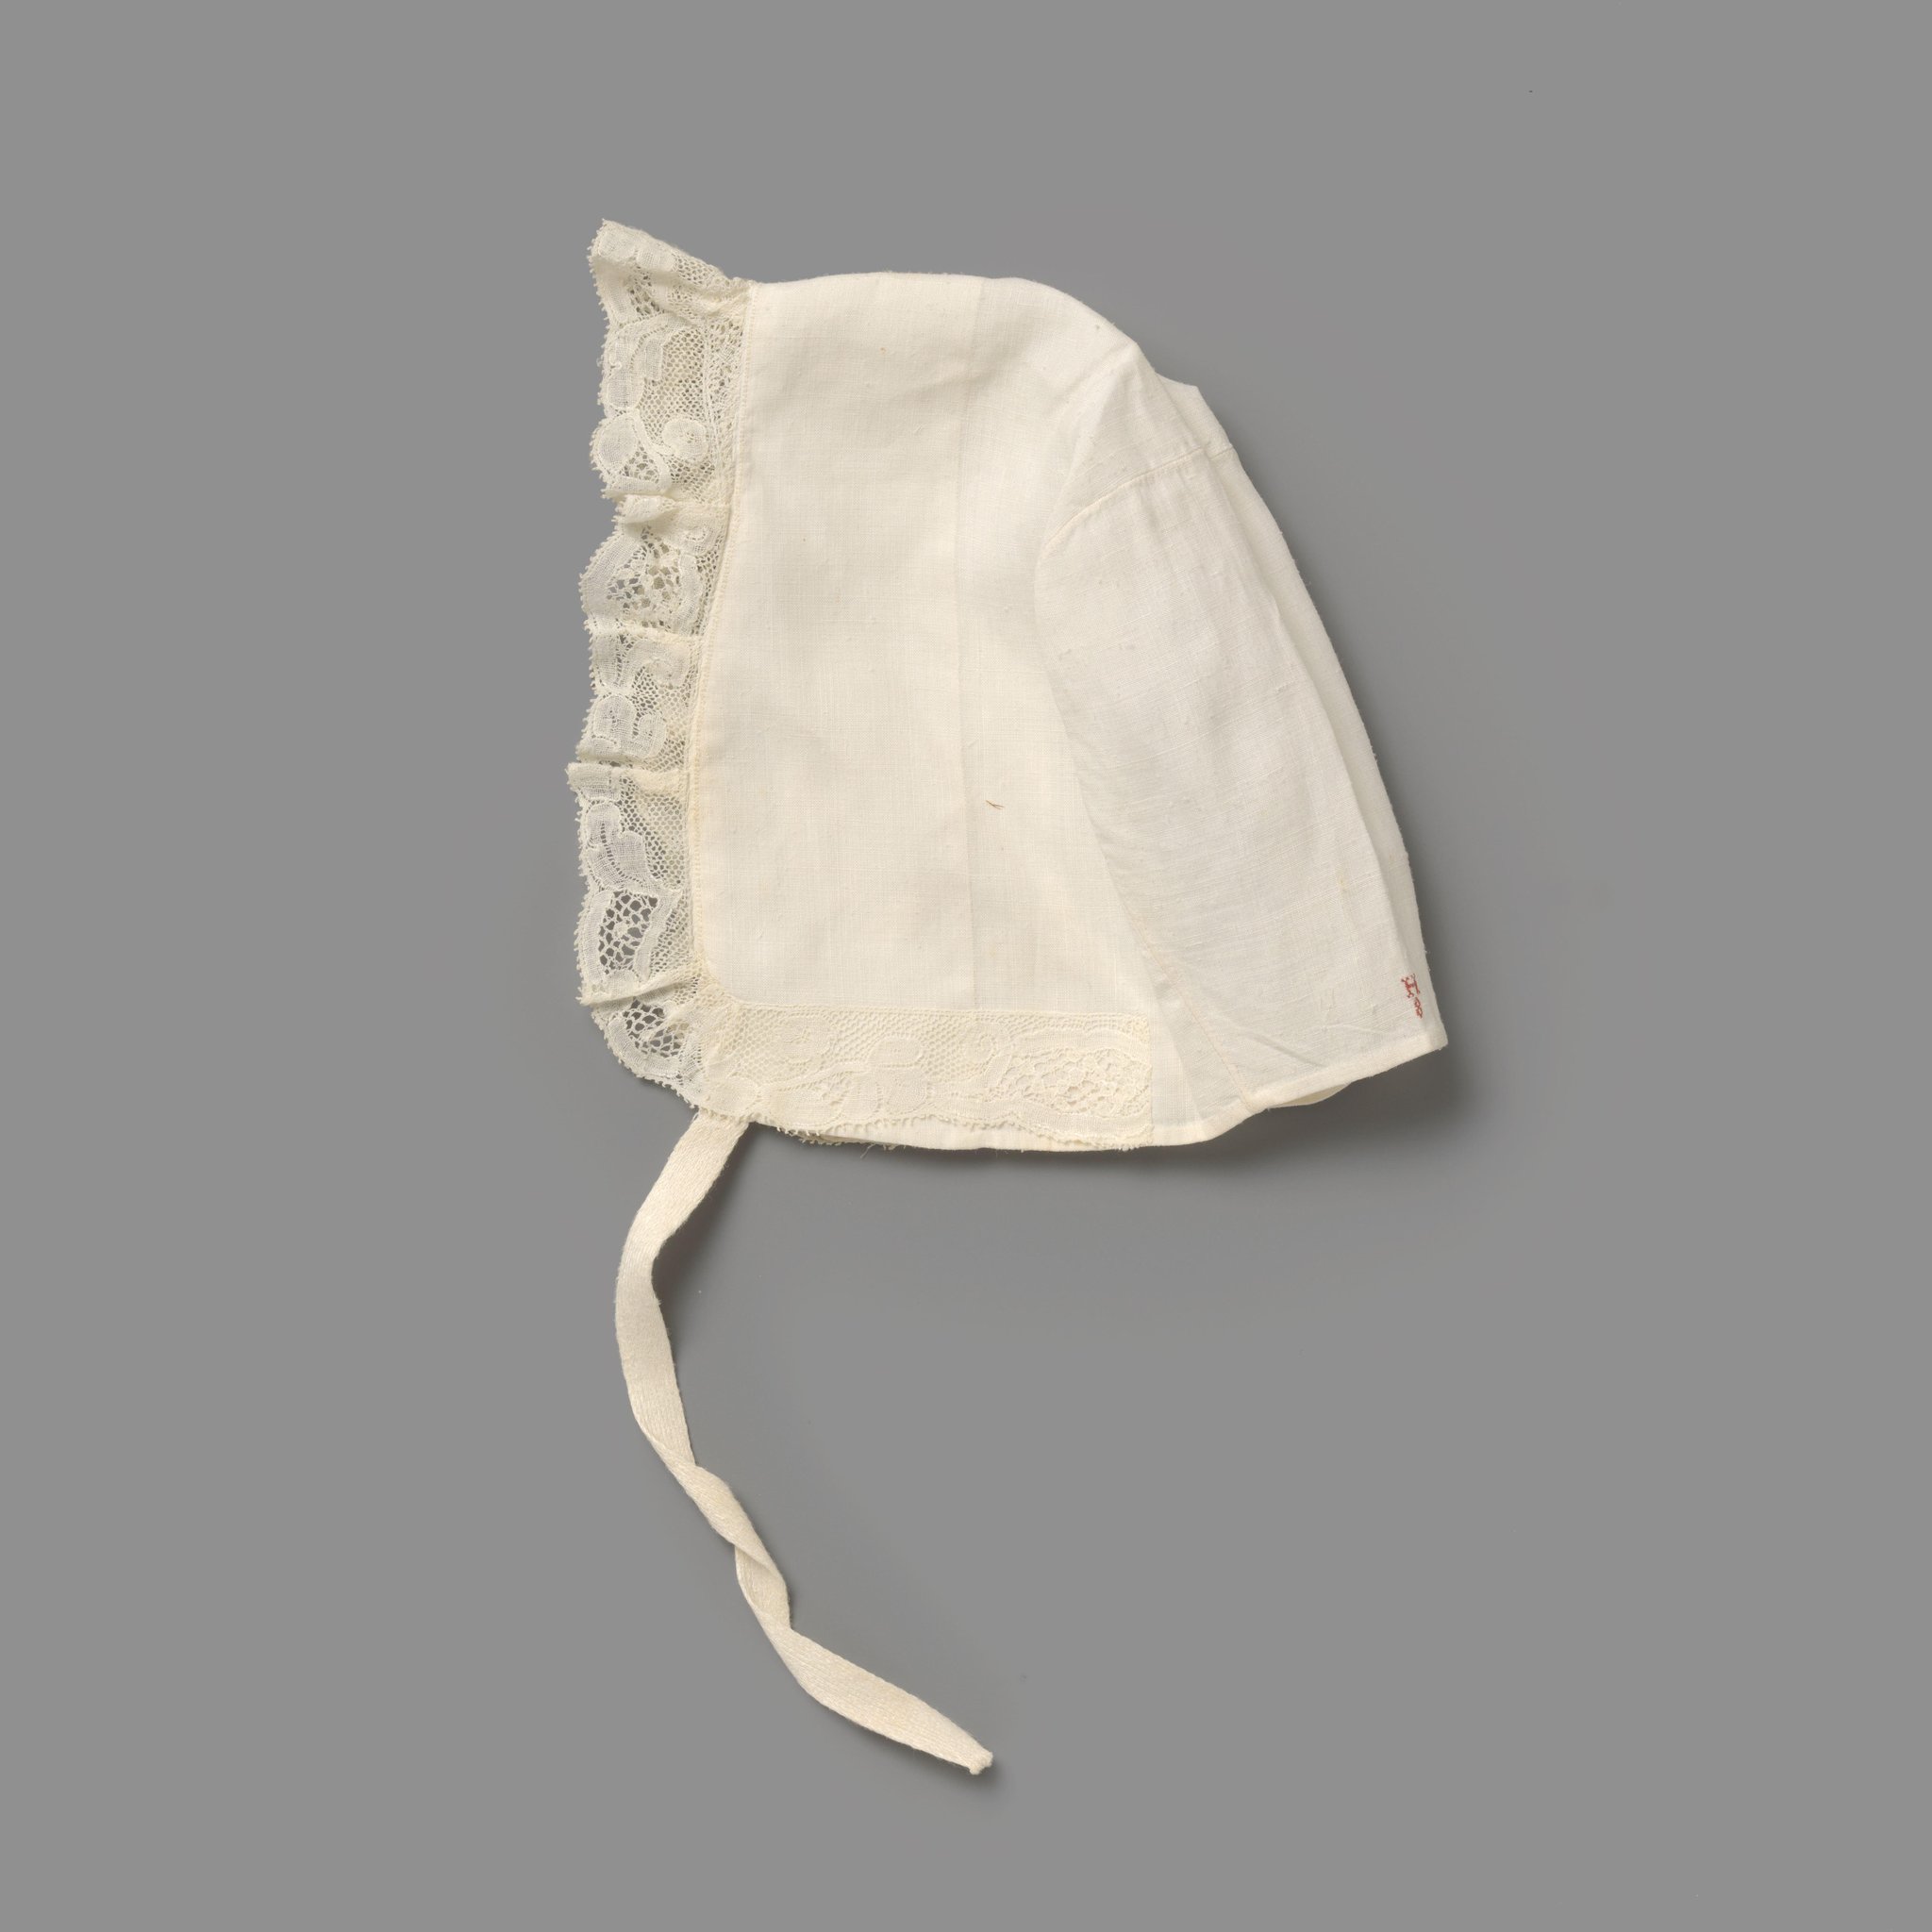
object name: childrenswear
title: Kindermuts van wit katoen (?) afgezet met kant en genummerd in rode kruissteek met H8; twee strikbanden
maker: Anonymous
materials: cotton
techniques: cross stitching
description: Linnen baby onder mutsjes, met kant langs voor en zijkantne gem. H8.